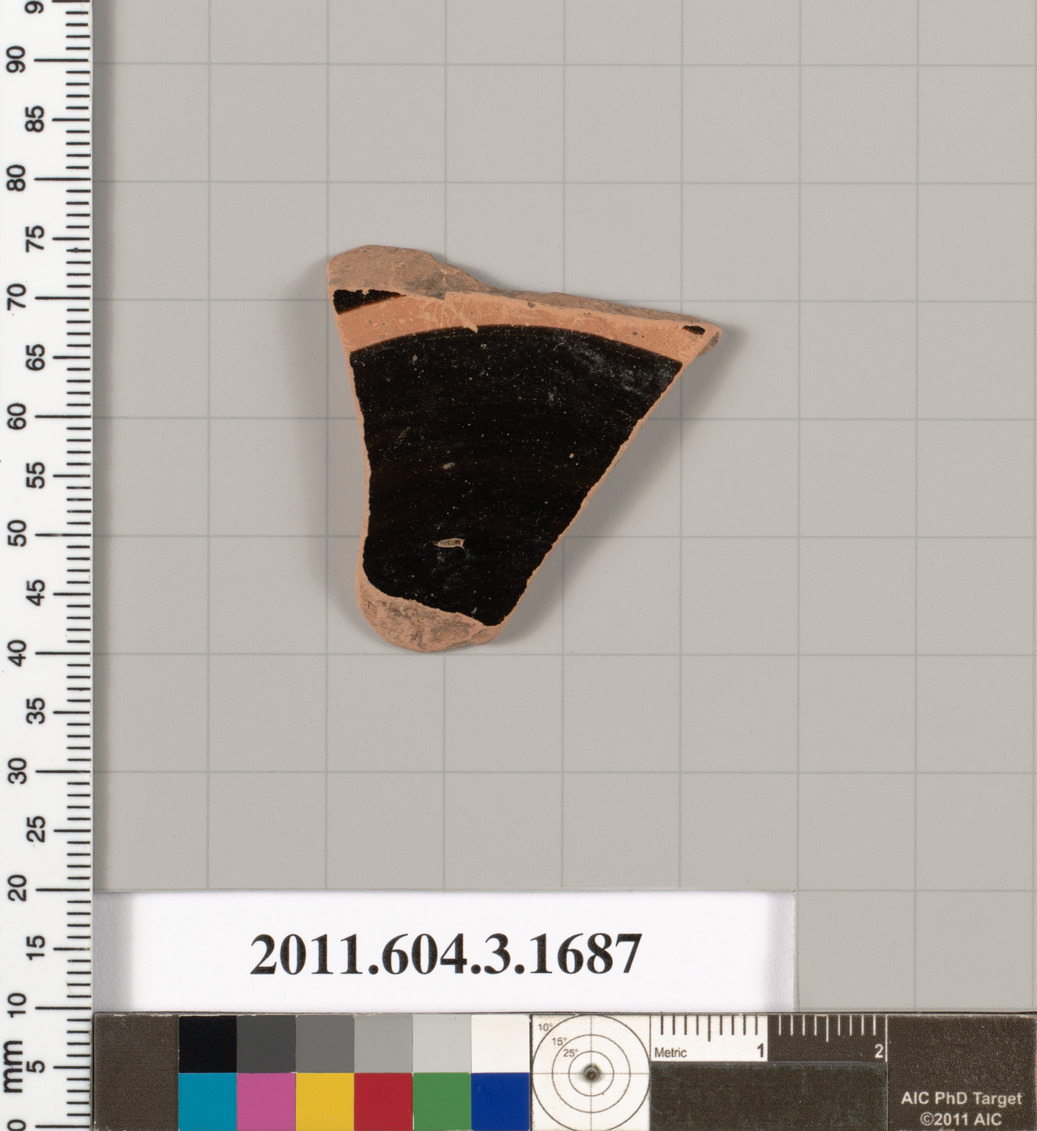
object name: kylix fragment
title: Terracotta fragment of a kylix: Band or lip cup (drinking cup)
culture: greek, attic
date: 550-526 BCE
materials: terracotta